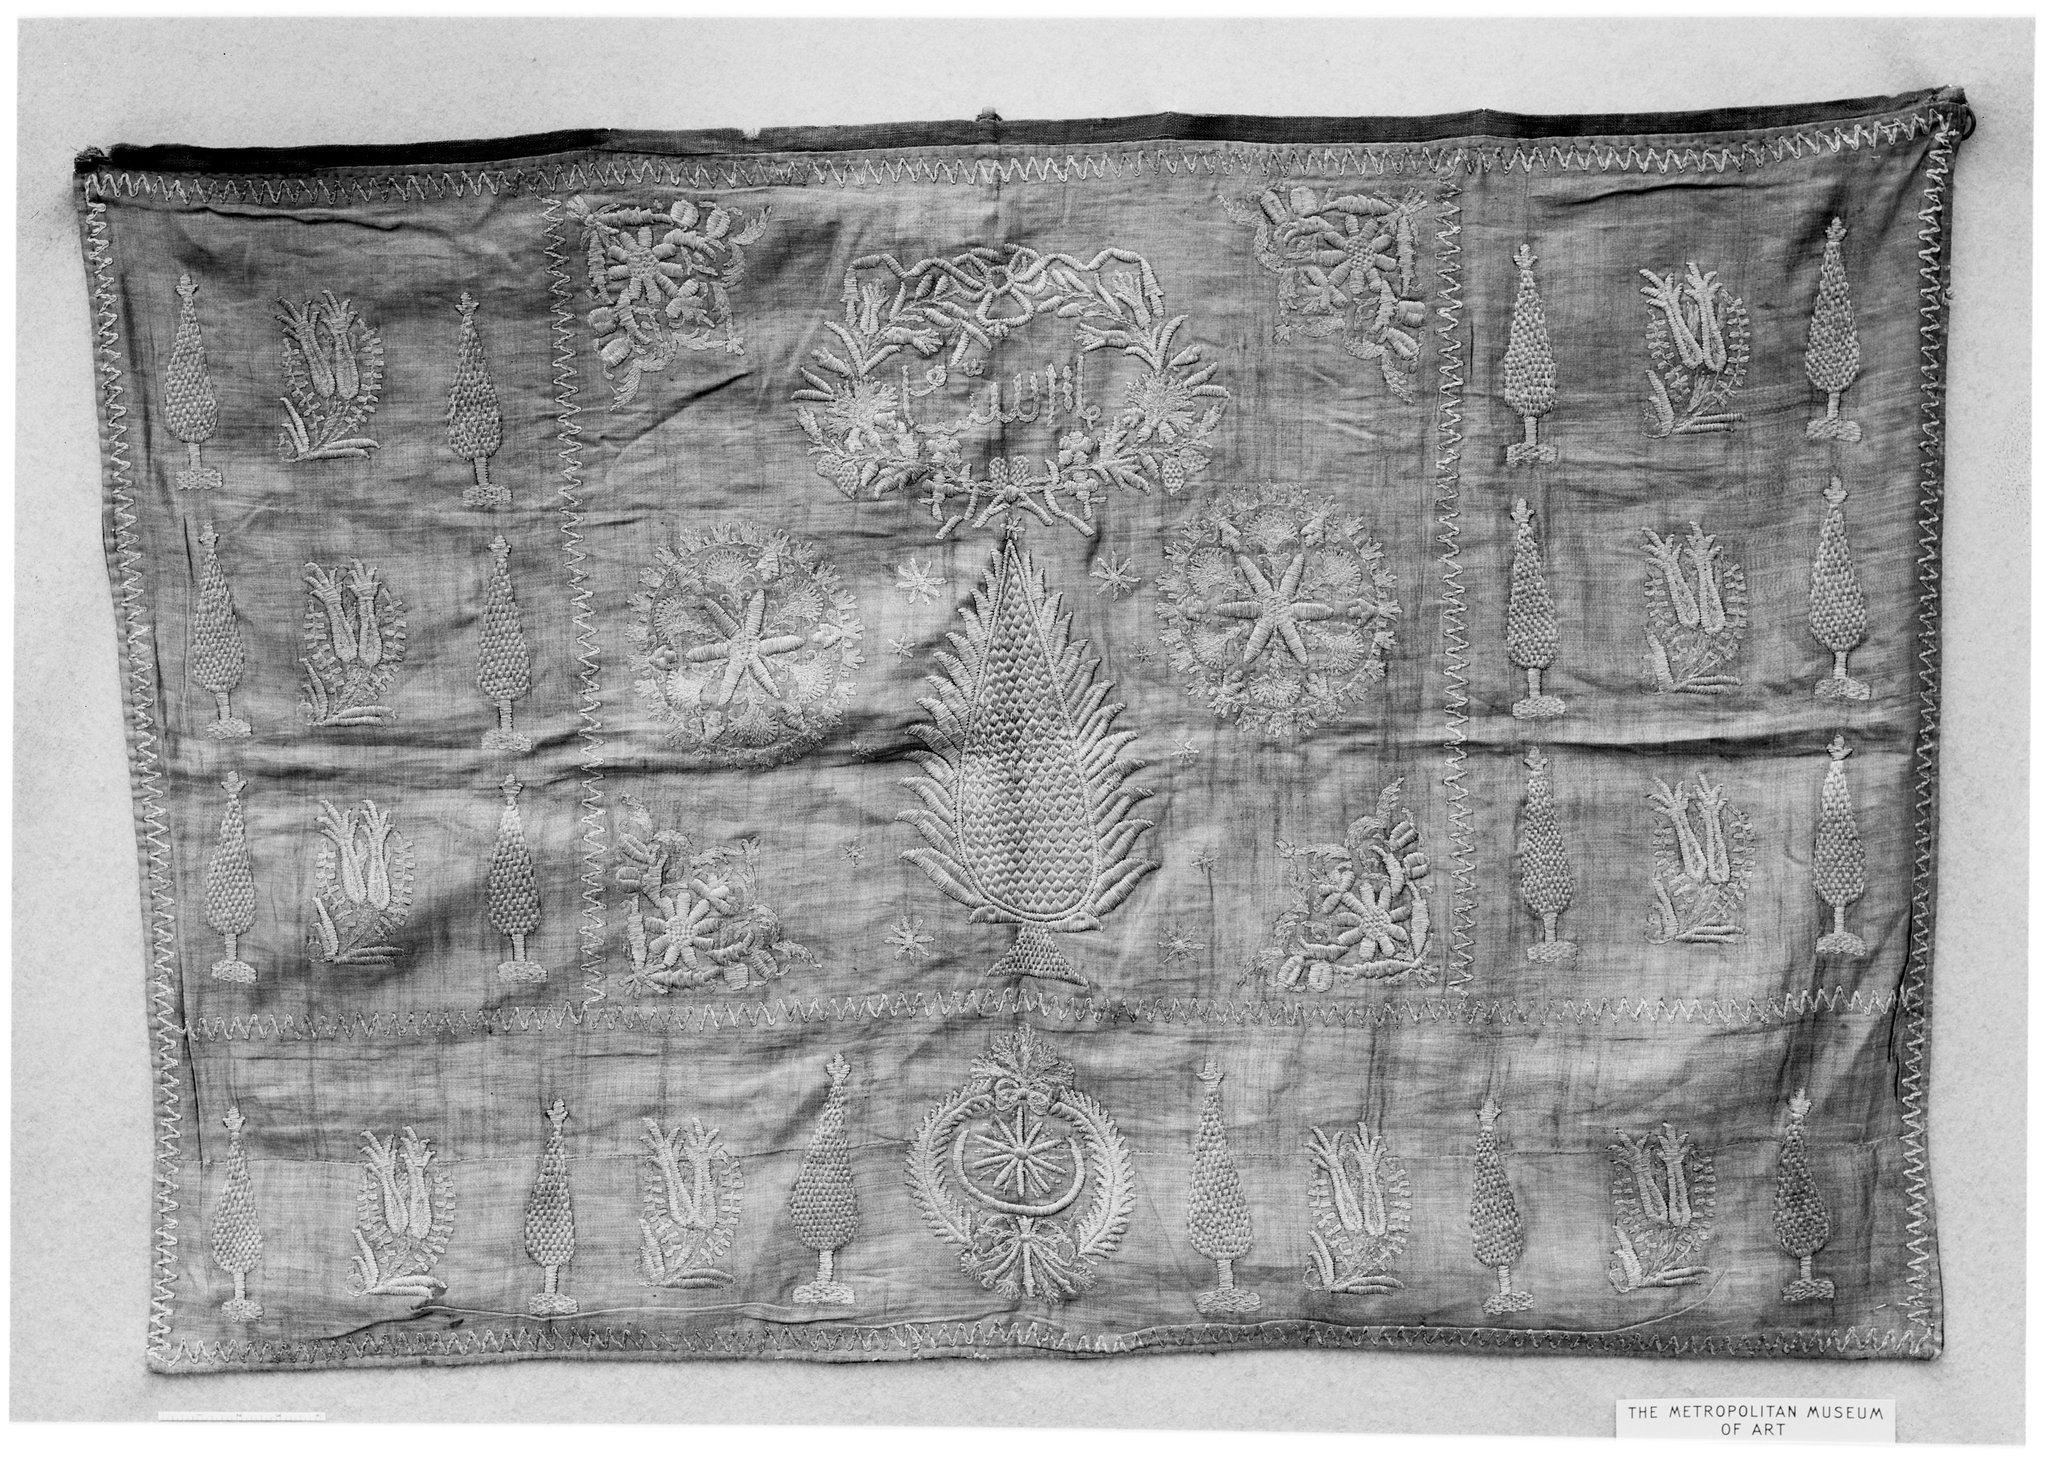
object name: cover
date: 1801-1833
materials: metal thread, silk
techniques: embroidery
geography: turkey